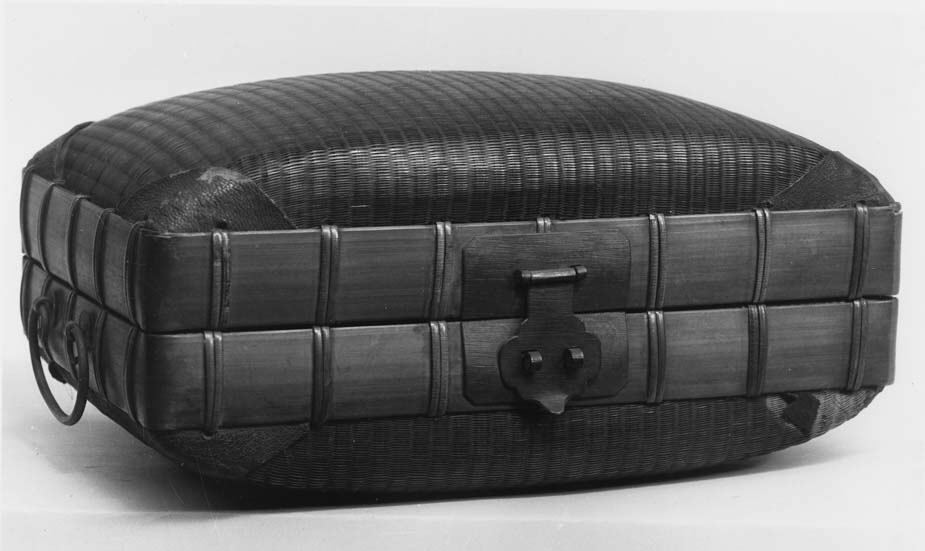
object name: handbag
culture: japanese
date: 1801-1900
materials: bamboo, cotton, leather, metal